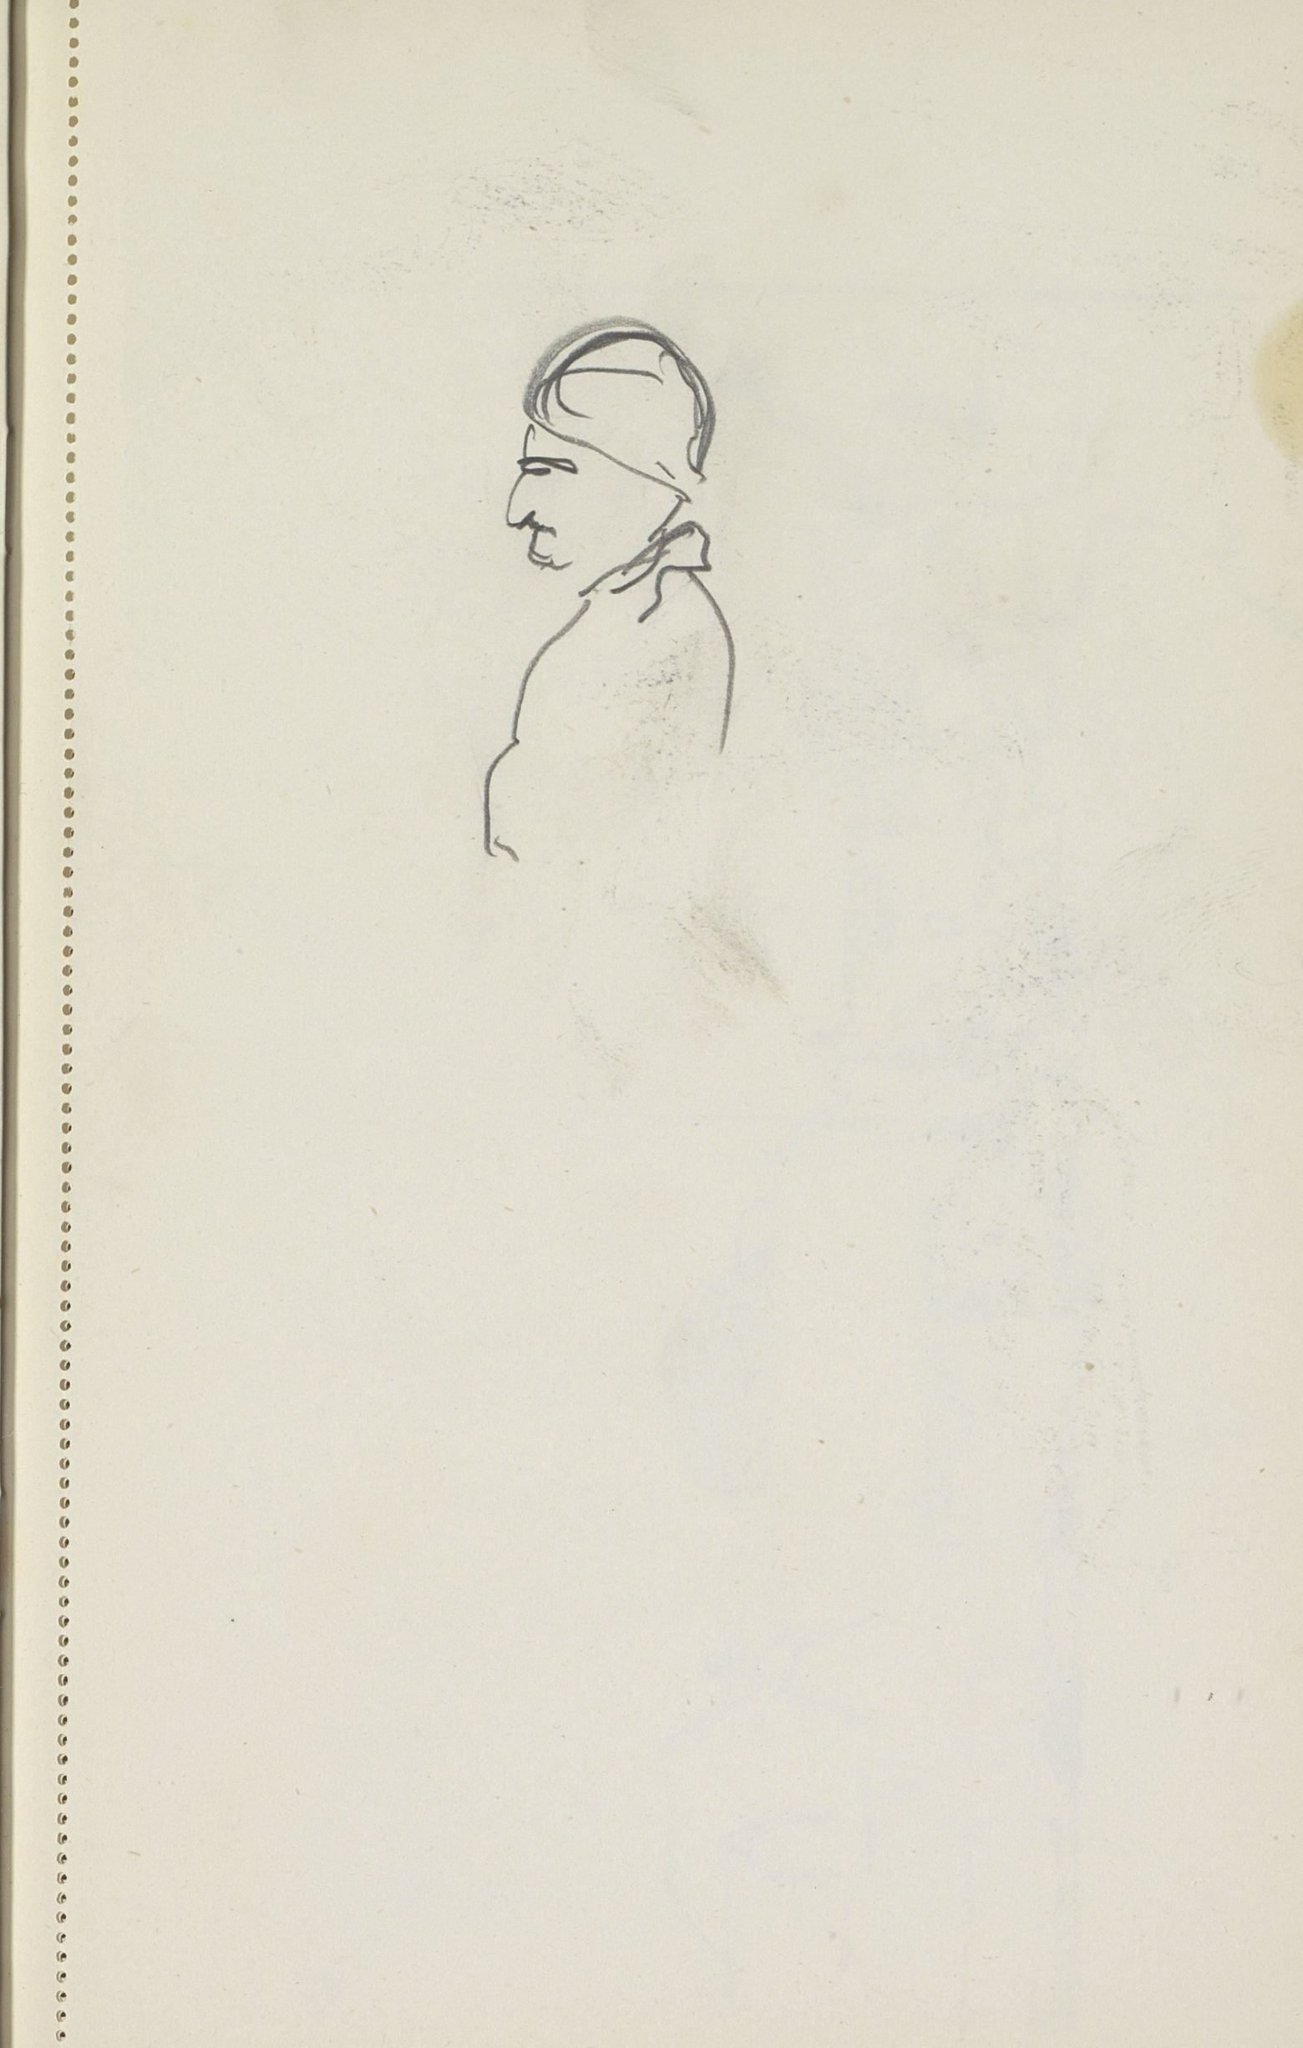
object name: sketchbook leaf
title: Man met een tulband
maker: cornelis vreedenburgh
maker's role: draughtsman, print maker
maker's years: 1880-1946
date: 1890-1946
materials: paper, pencil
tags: head (human), head-gear: turban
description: Blad 44 recto uit een schetsboek met 50 bladen.